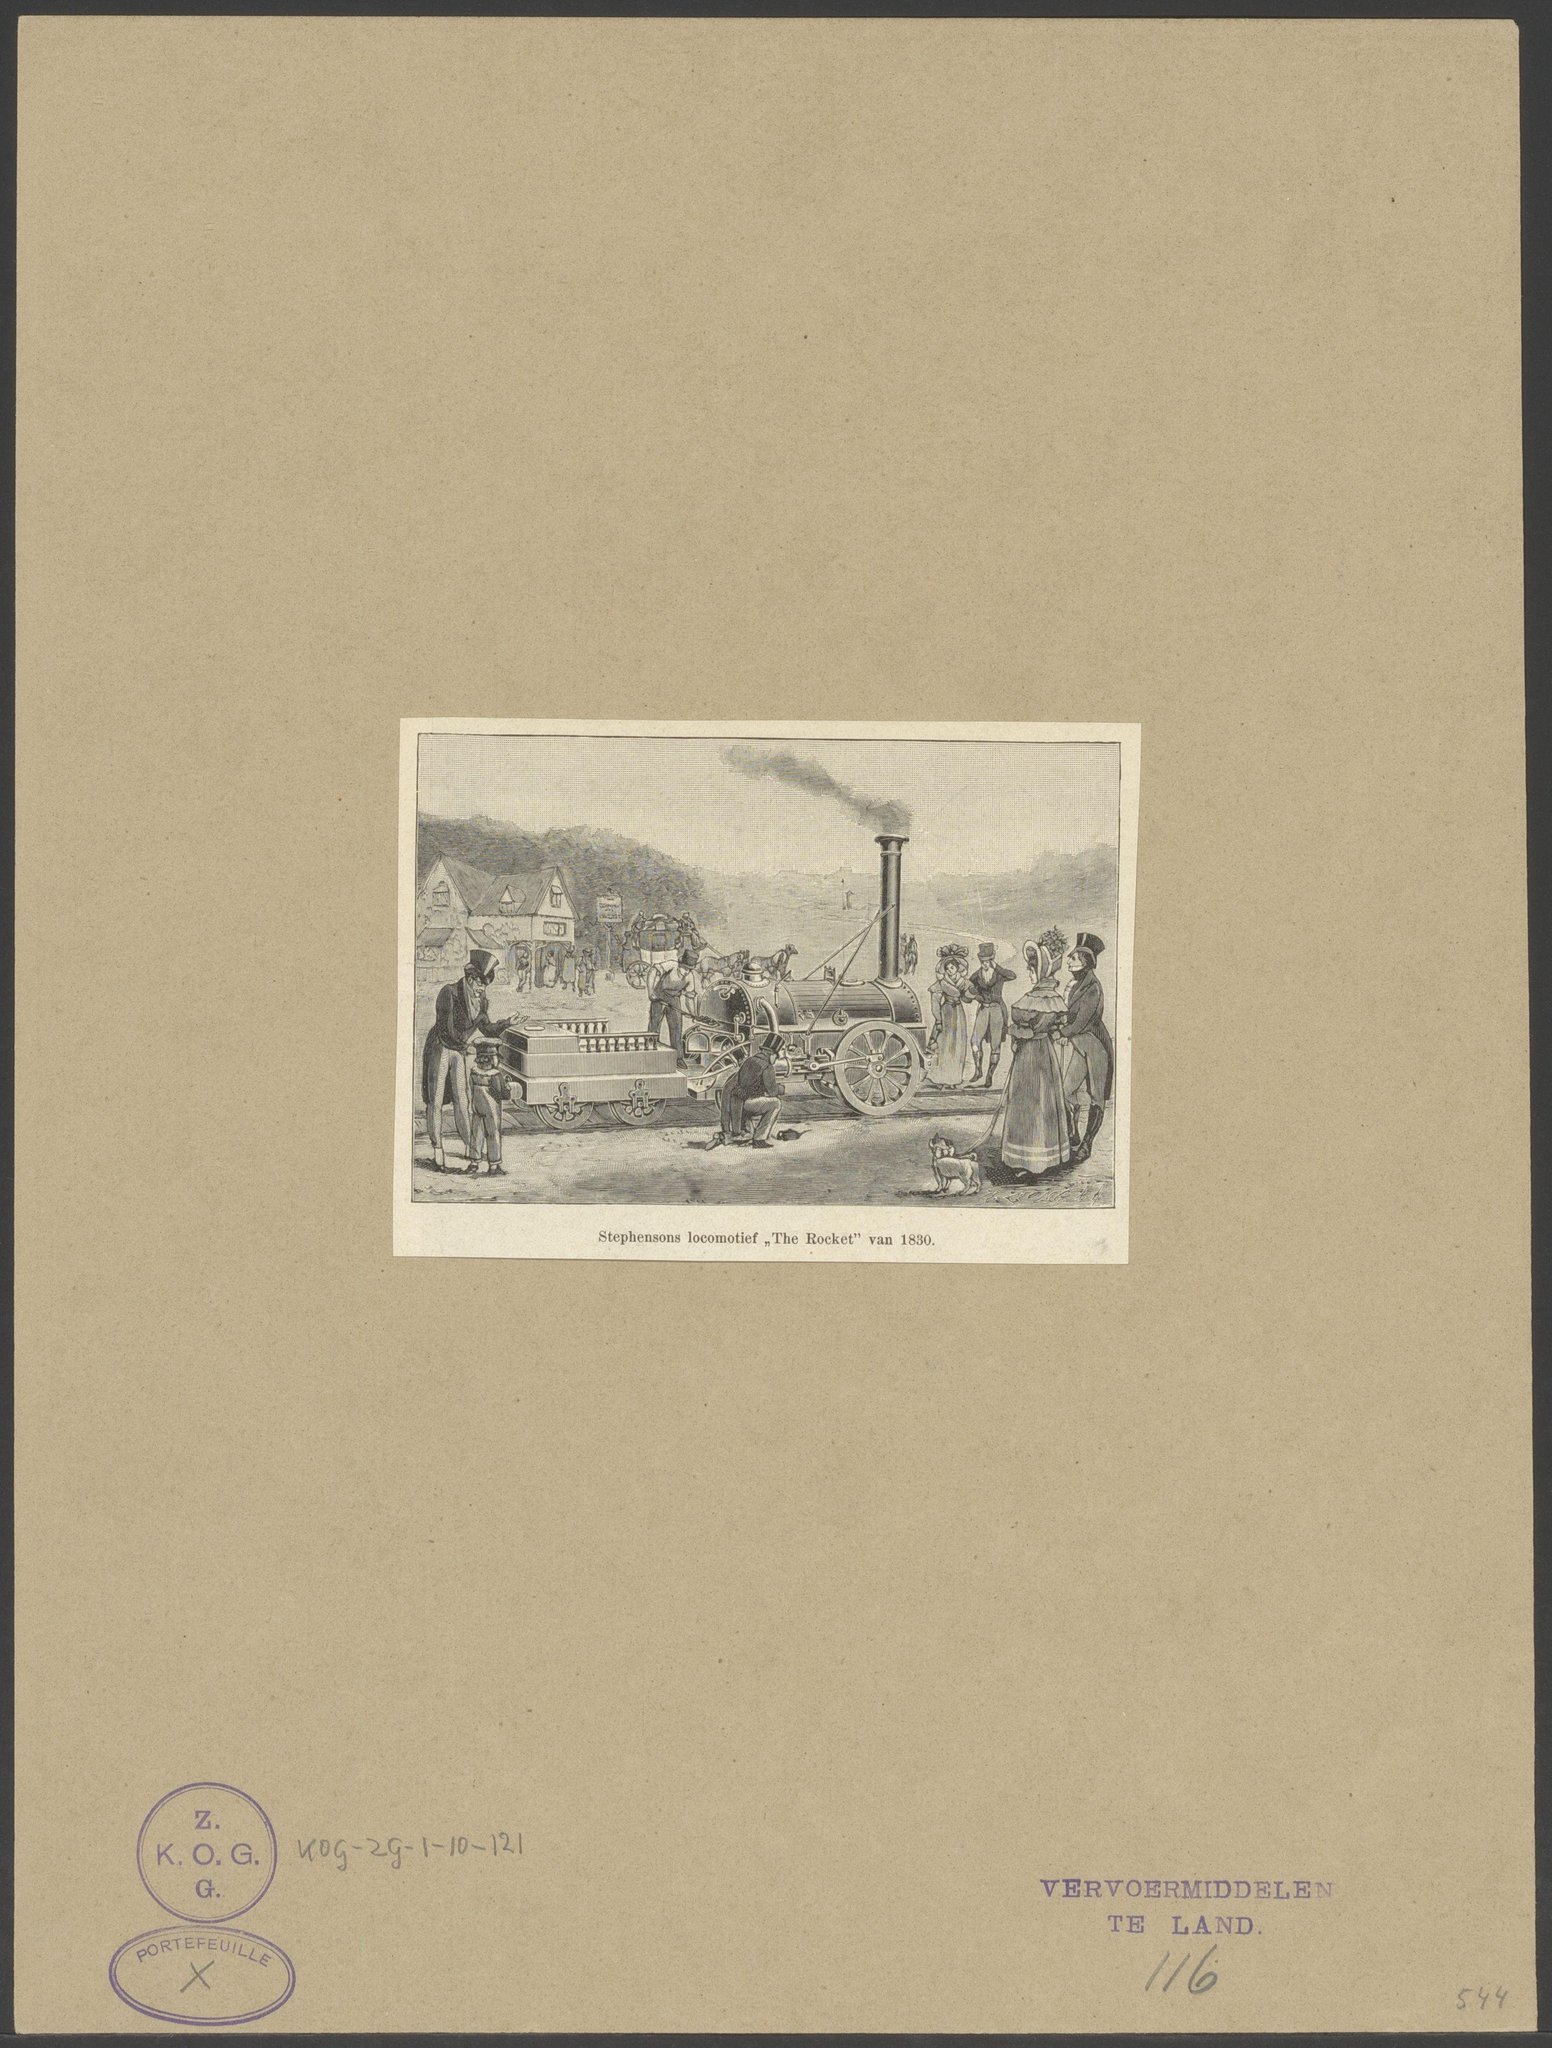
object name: print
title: Stephensons locomotief "The Rocket" van 1830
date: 1897-1899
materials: paper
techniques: letterpress printing, engraving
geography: leiden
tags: locomotive, station; shelter (railway, tramway)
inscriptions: stamp, stamp, signature: ‘B. Long X.A.’, collector's mark: Lugt 1641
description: De locomotief Stephenson's Rocket uit 1830. Onderwerpsrubrieken binnen de Atlas Zeden en Gewoonten: Handel, nijverheid en verkeer, Vervoermiddelen te land en te water, vervoermiddelen te land, Spoorwegen.